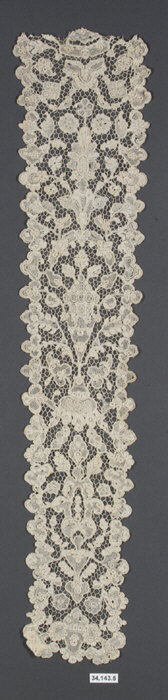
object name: lappet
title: Lappet (one of a pair)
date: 1701-1800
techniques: lace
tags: flowers